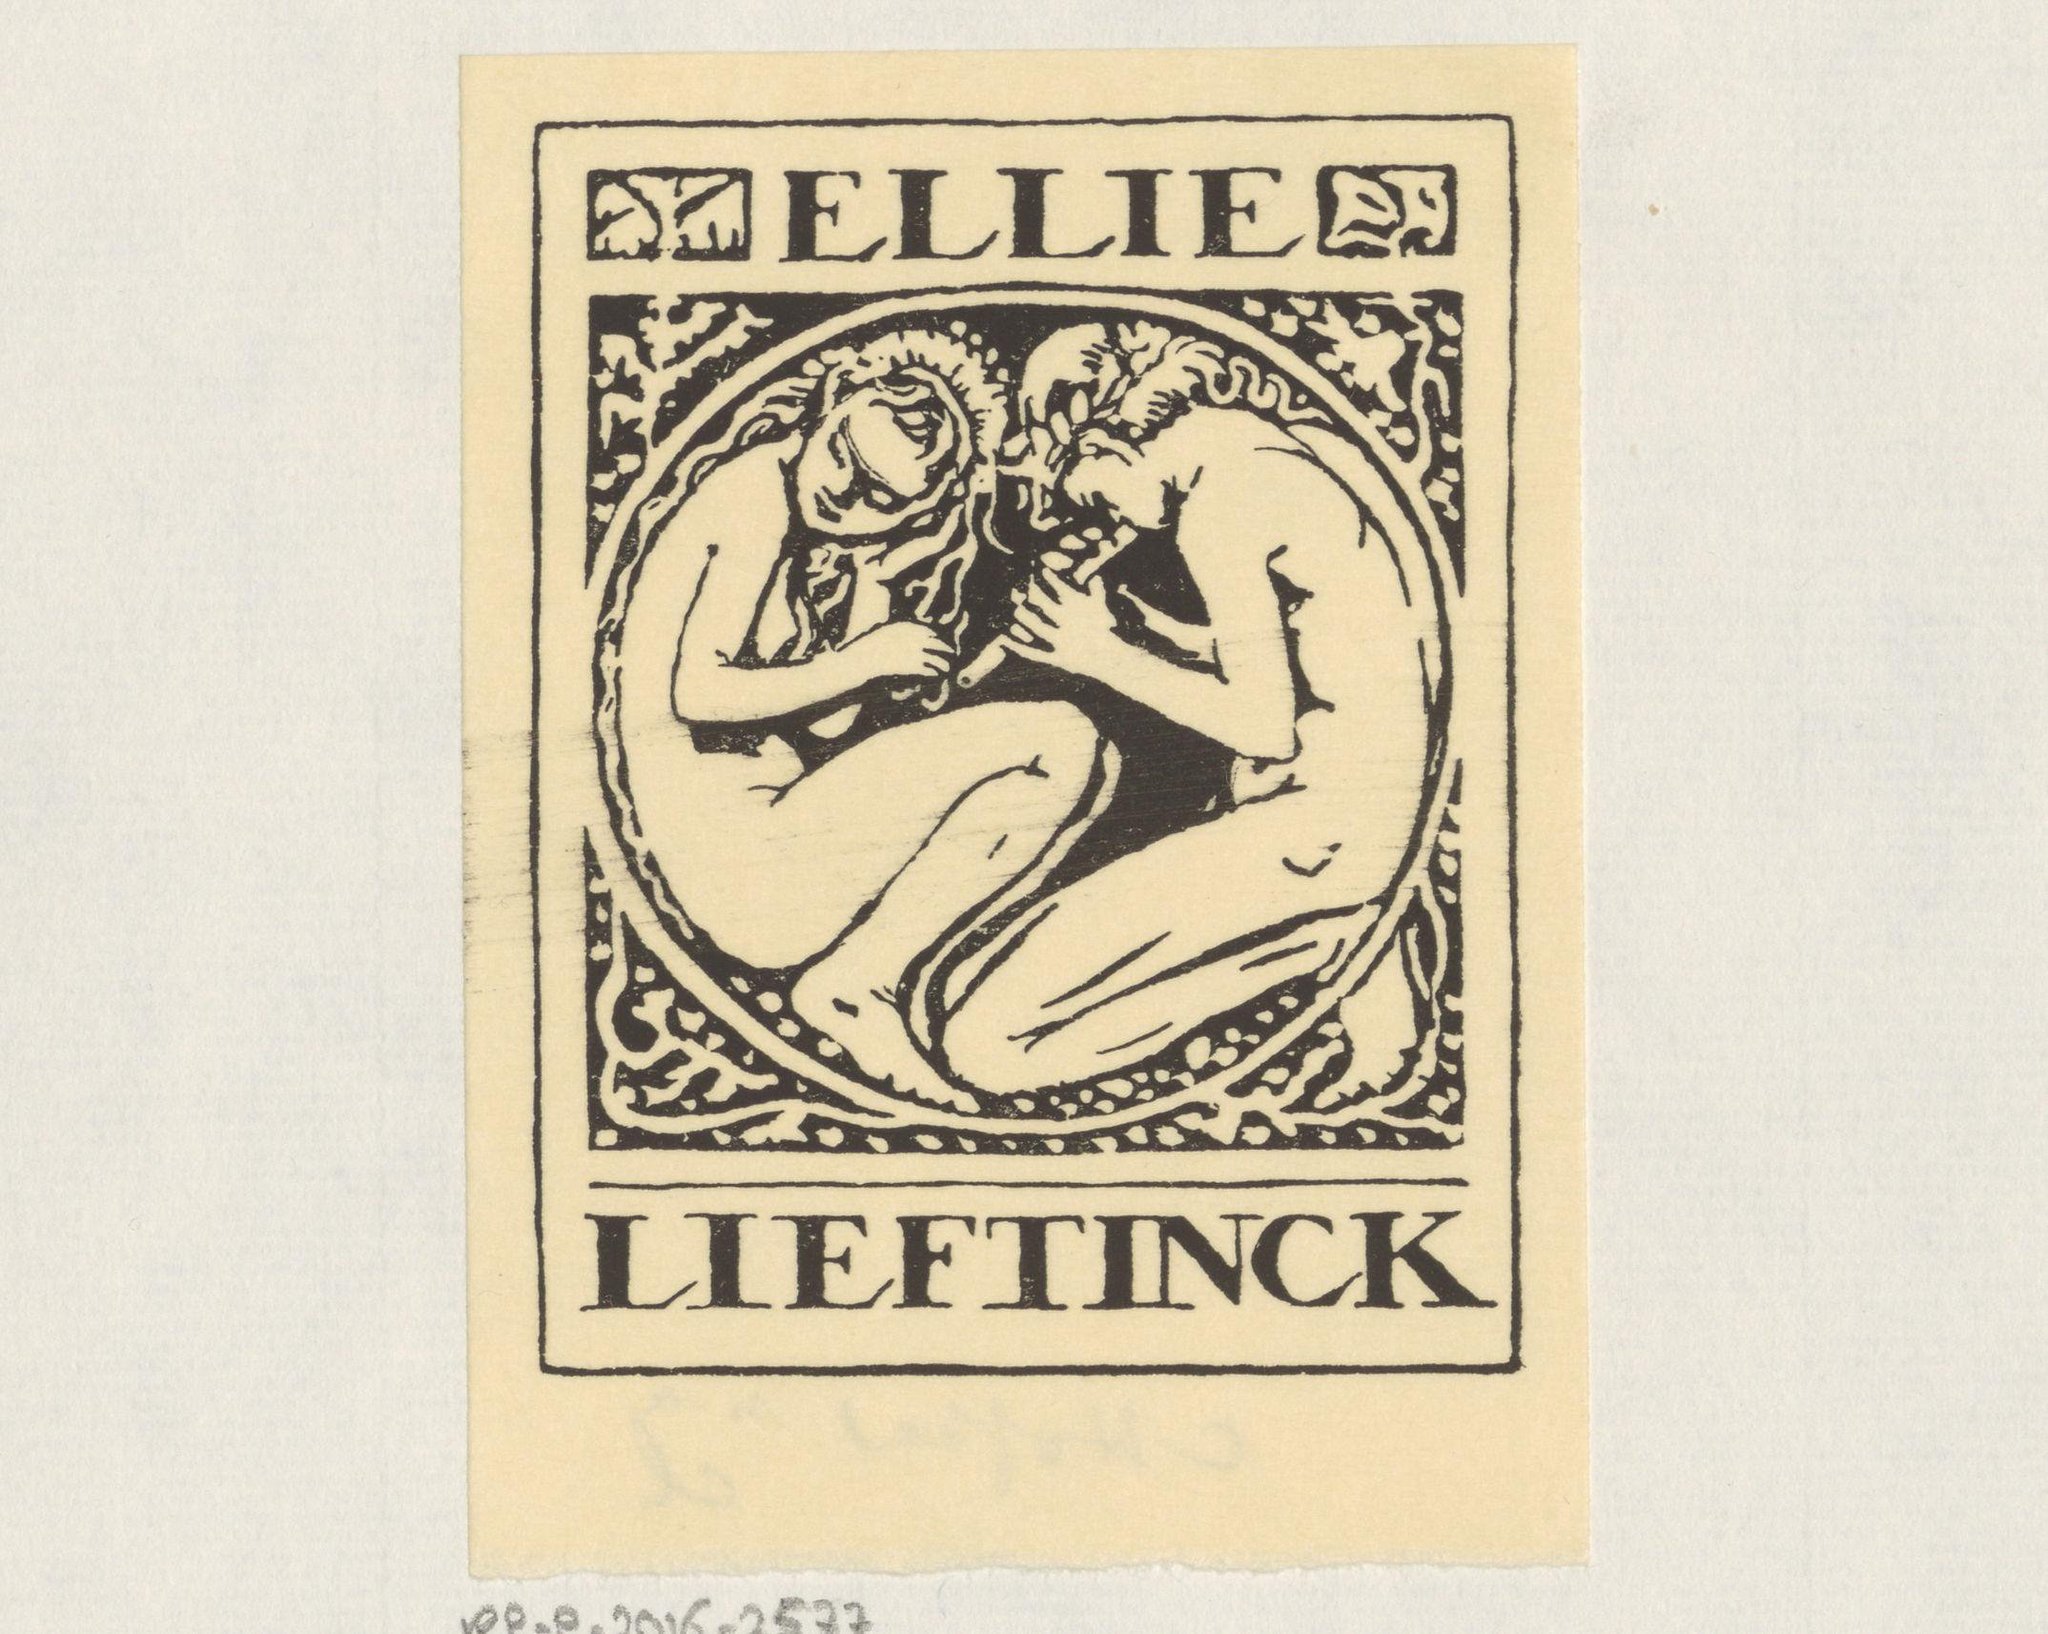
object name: bookplate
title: Ex libris van Ellie Lieftinck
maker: c. hofker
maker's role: print maker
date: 1850-1950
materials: paper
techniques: printing block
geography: netherlands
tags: satyrs, fauns, sileni, male bacchant(es), couple of lovers, flute, aulos, tibia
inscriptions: signature: ‘C. Hofker / cl’